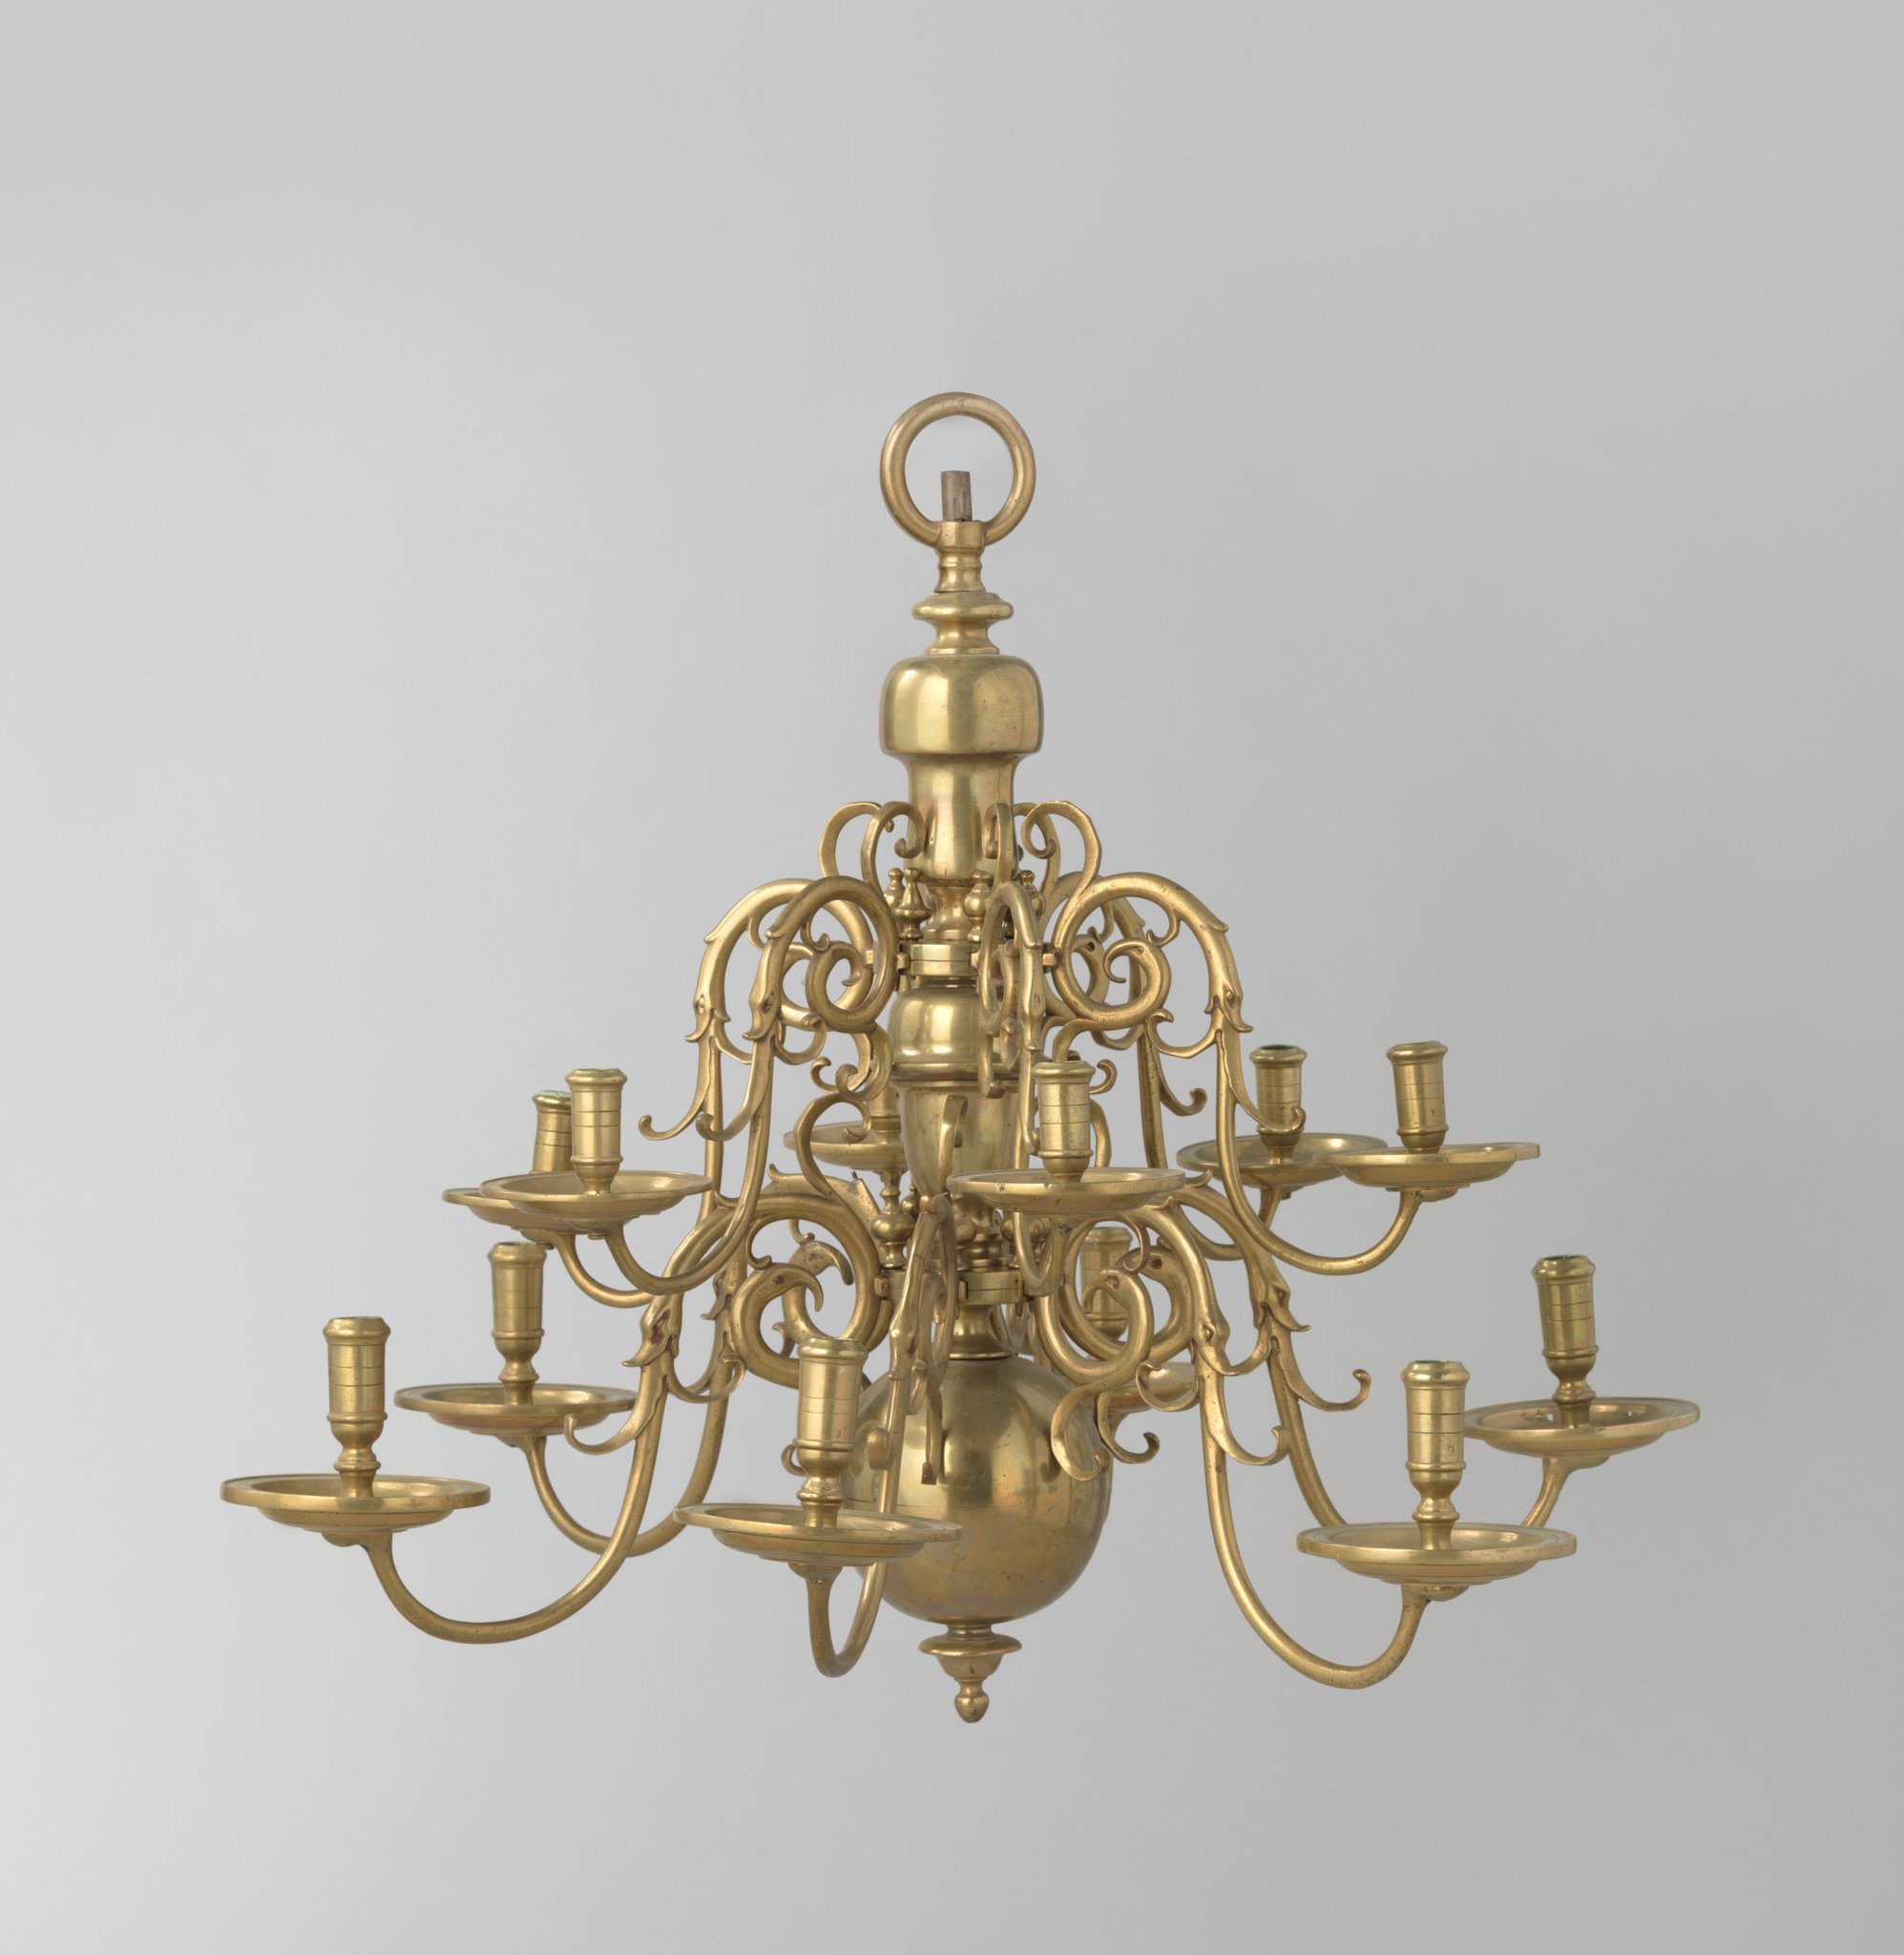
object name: chandelier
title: Stam van kaarsenkroon van twee hoogten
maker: Anonymous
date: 1800-1875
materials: brass, iron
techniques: casting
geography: netherlands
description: Het voorwerp bestaat uit een ronde stang van gietijzer, een ijzeren splitpen en de volgende delen van geelkoper: de hangring, een stamdeel in paddenstoelvorm, een standring, een stamdeel in balustervorm, een standring, een holrond tussenstuk, de bol, de knop. Beide standringen hebben ter bevestiging van de zes armen openingen, die ongemerkt zijn dan wel gemerkt met één t/m vijf ingeslagen stippen. De aan de stang gesmede knop kraagt breed uit en eindigt in een knopje. De geheel ronde stang heeft bovenaan een smalle spleet voor de splitpen. De pinnen hebben grove vaasvormige knoppen. Het is te zien, dat de bol in twee helften is gegoten.